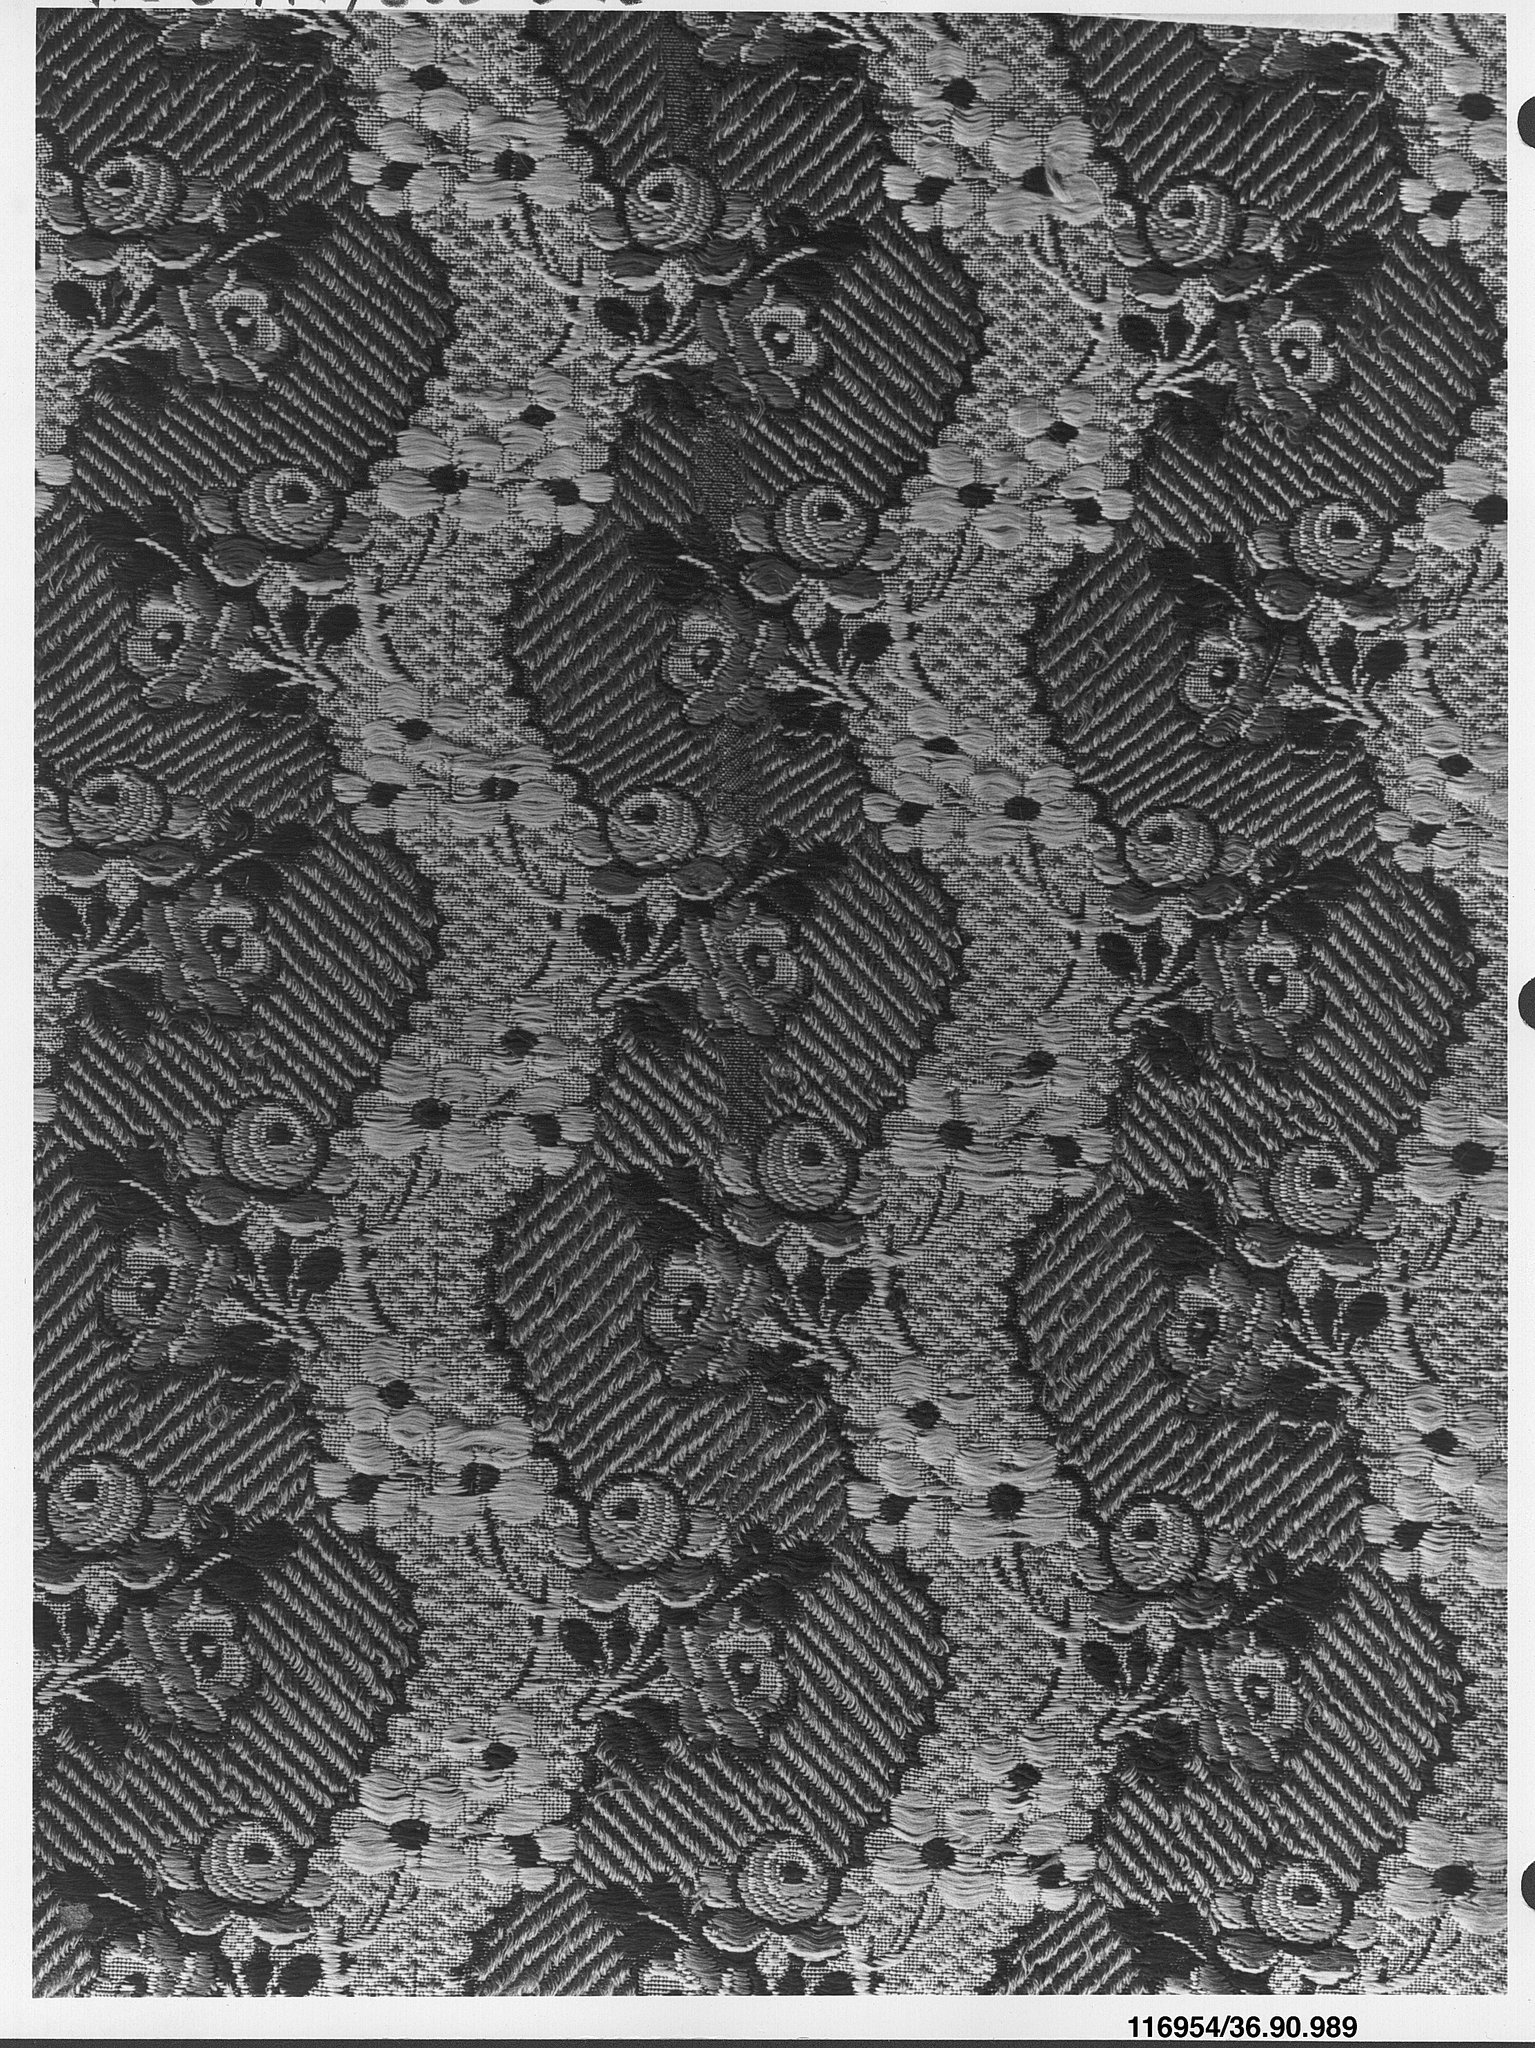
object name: piece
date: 1701-1800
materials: silk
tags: flowers,leaves